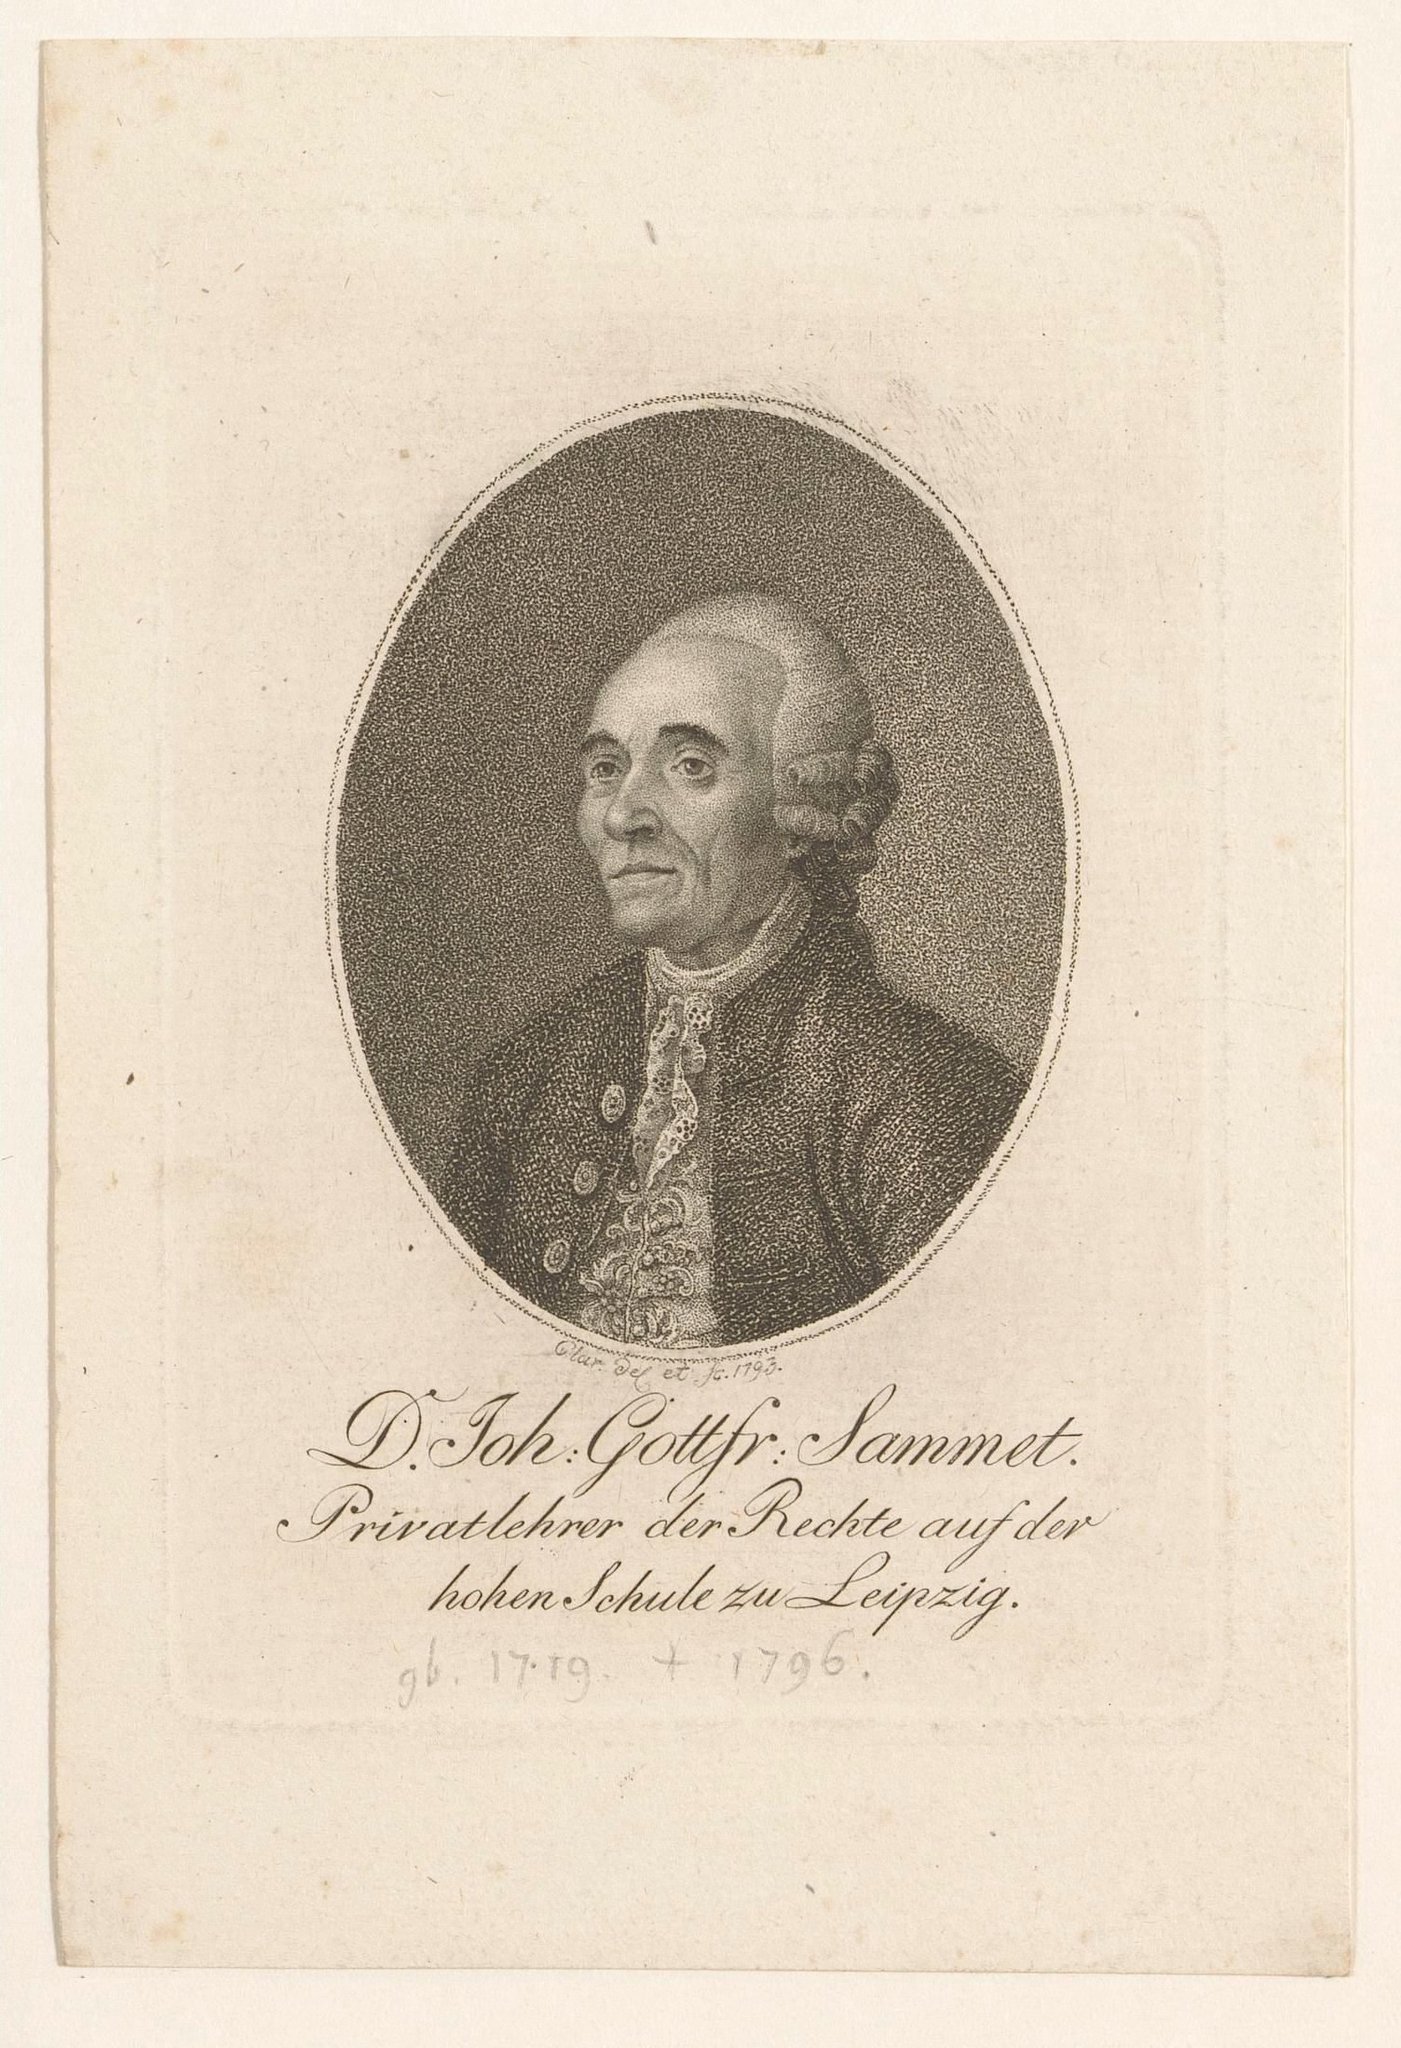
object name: print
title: Portret van Johann Gottfried Sammet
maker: johann friedrich august clar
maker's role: print maker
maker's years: 1768-1844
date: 1793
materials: paper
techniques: stippling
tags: historical persons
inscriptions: collector's mark: Lugt 2228